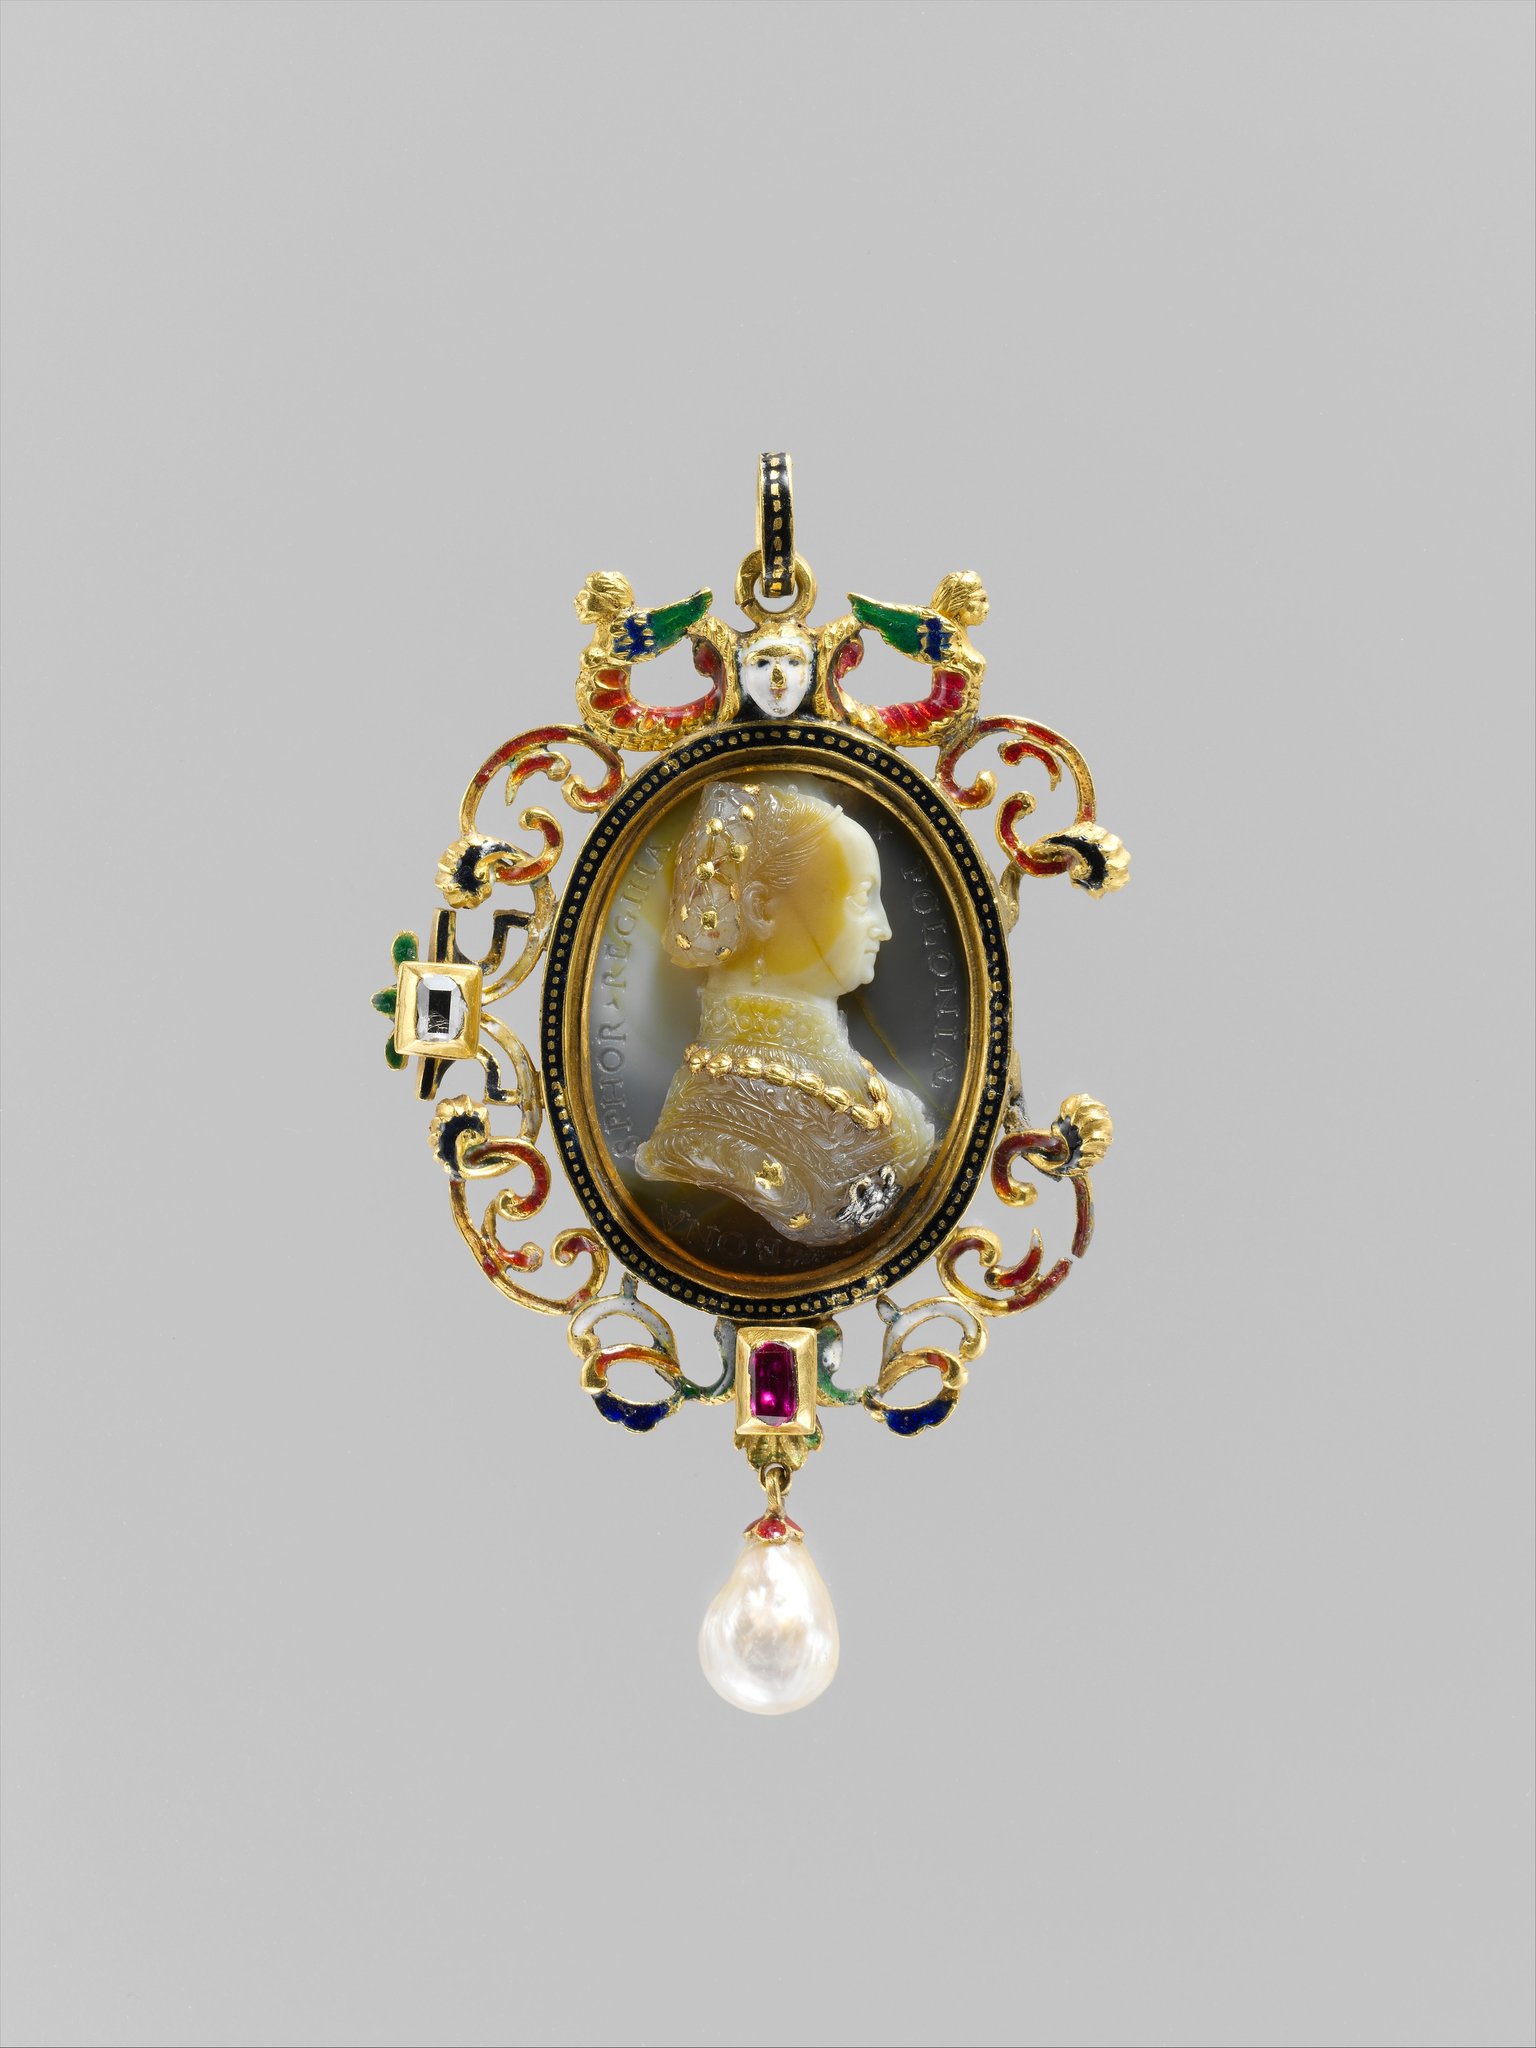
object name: pendant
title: Bona Sforza (1493–1557), Queen of Poland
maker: giovanni jacopo caraglio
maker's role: maker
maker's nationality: italian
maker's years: 1500-1565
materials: enamel, gold, pearl, gemstone, silver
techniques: inlay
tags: queens,women,coat of arms